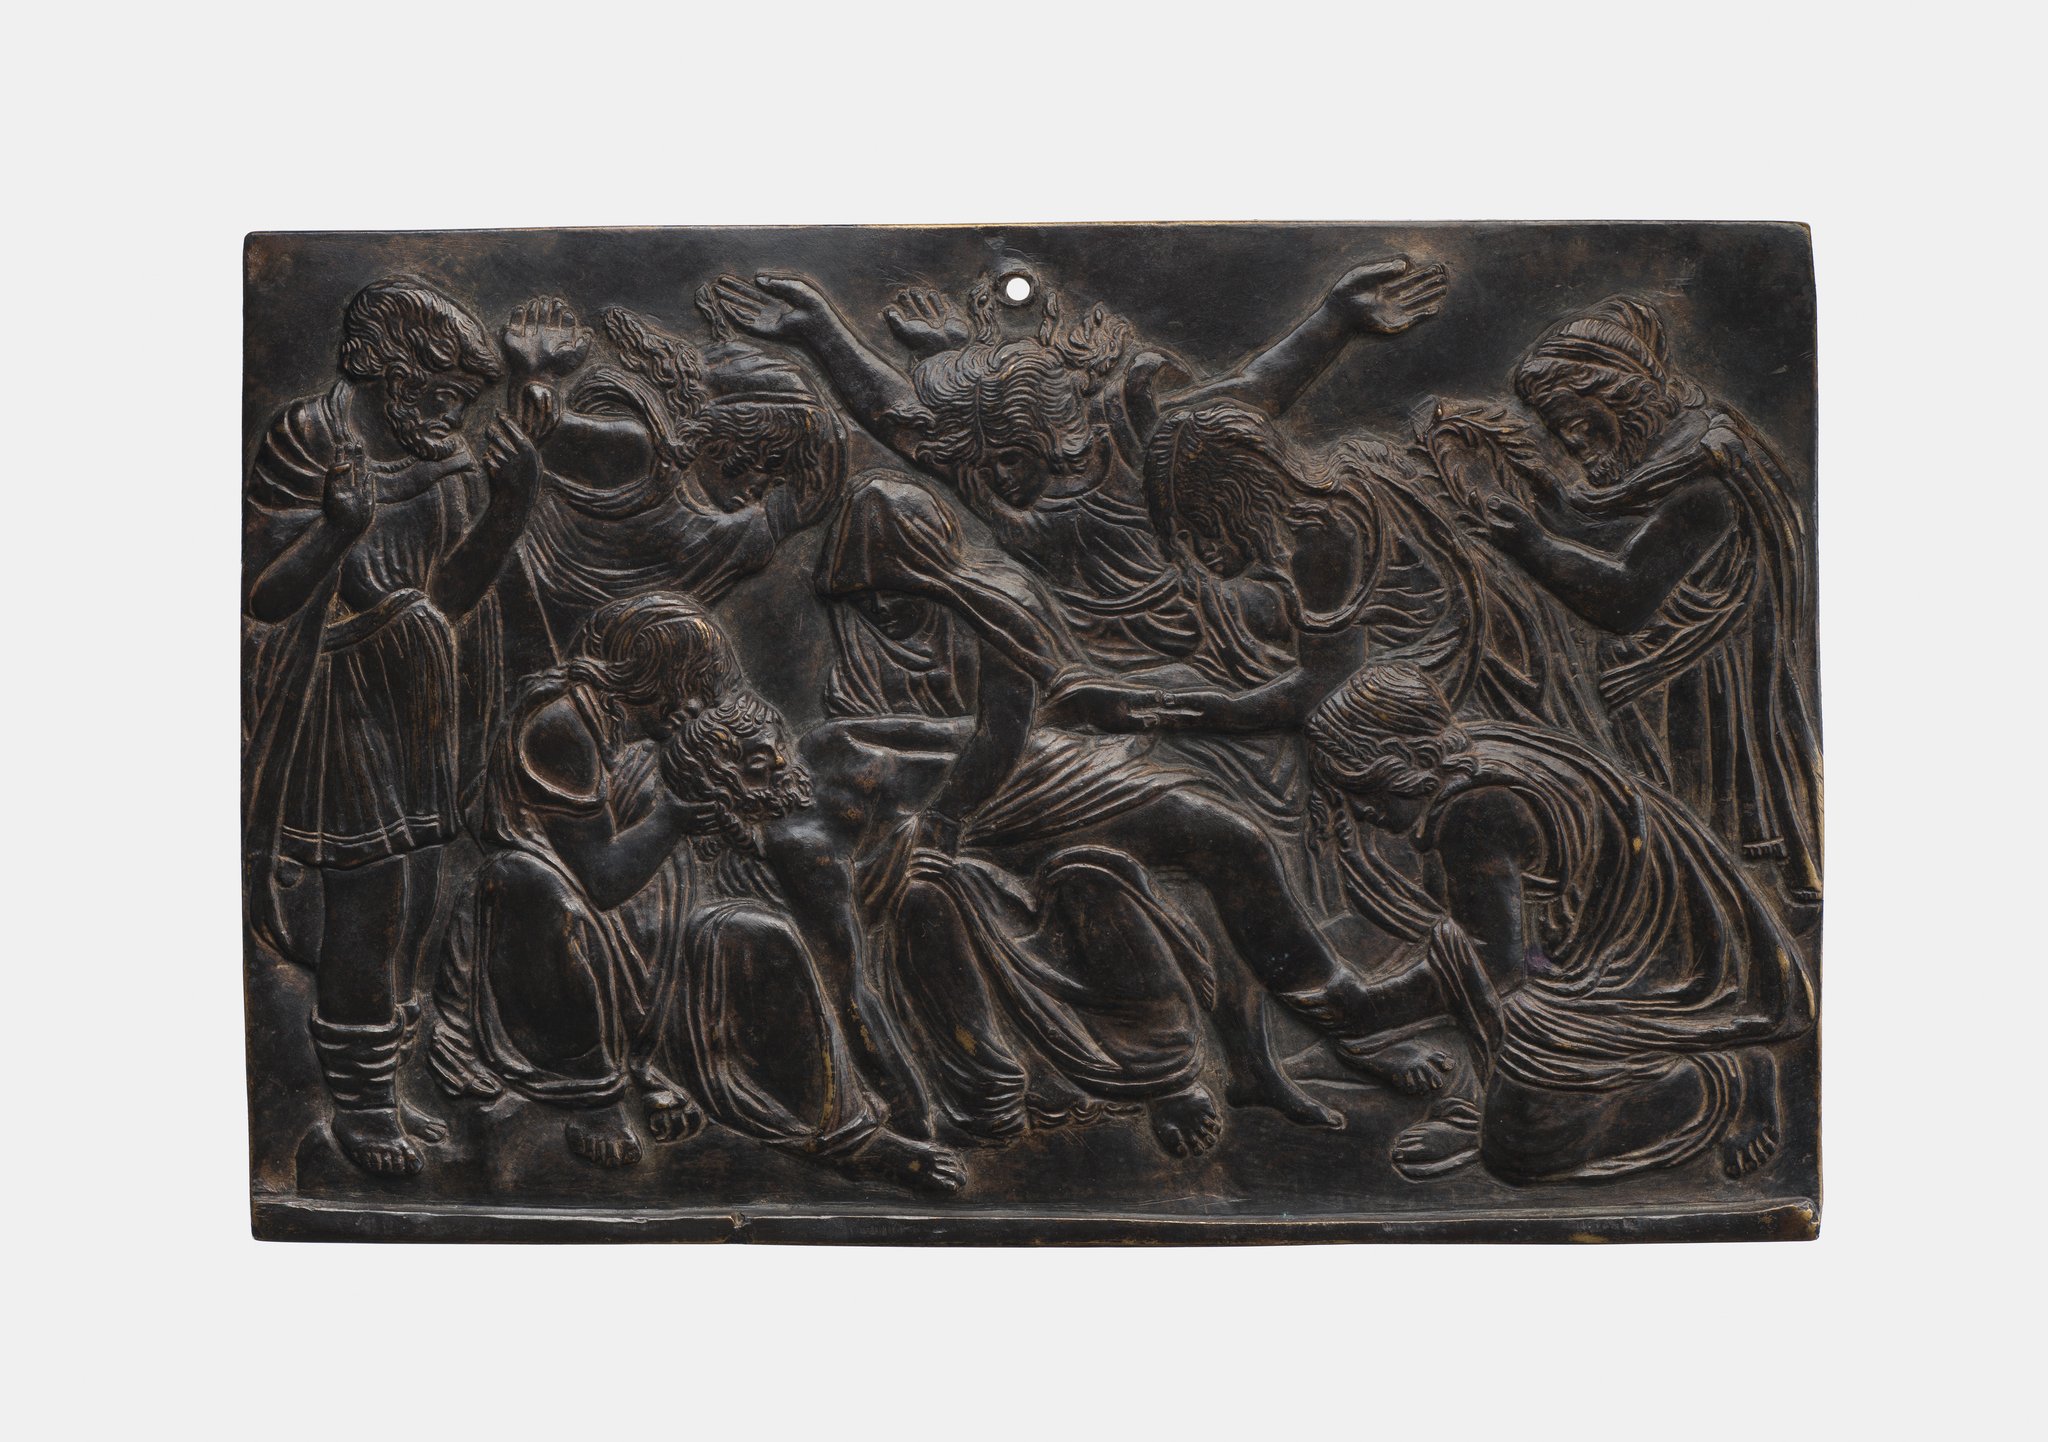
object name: plaquette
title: Pietà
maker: bertoldo di giovanni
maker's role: artist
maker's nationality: italian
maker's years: 1430-1491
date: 1430-1440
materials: bronze